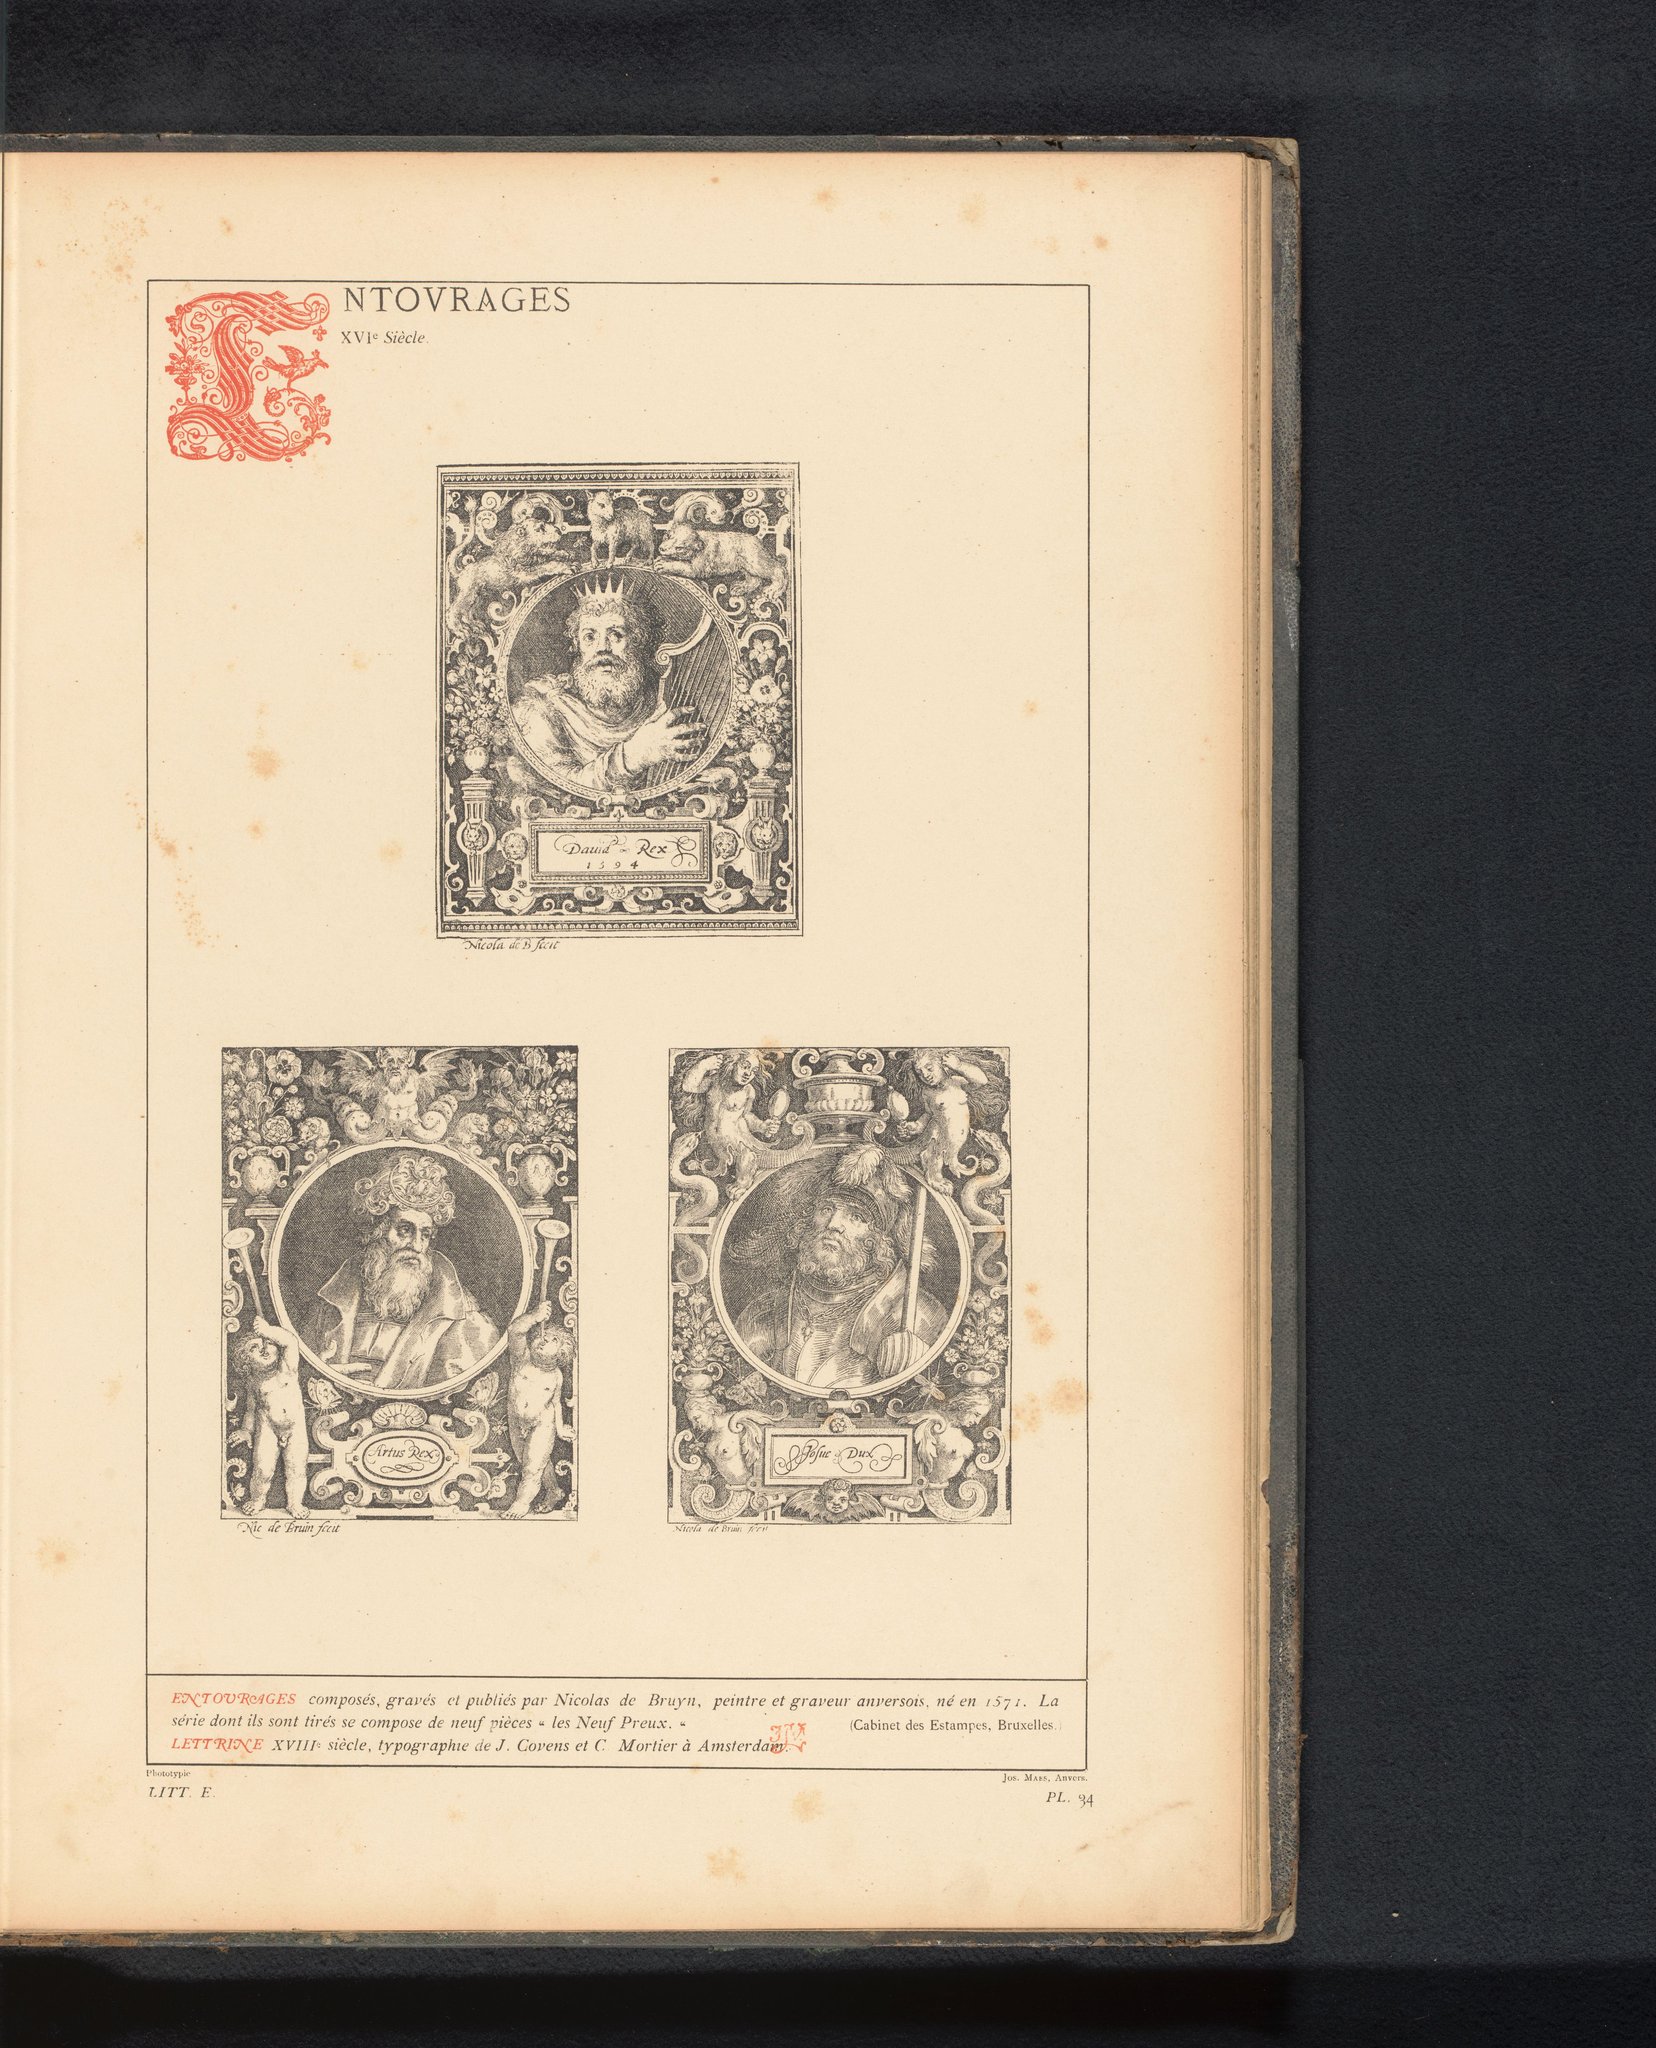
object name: reproduction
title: Reproductie van drie prenten van een portret omringd door grotesken door Nicolaes de Bruyn, afgebeeld Koning David, Koning Arthur en vermoedelijk Frederic Josue, hertog van Saksen-Coburg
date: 1875-1880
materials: paper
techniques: photolithography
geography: antwerp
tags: ornament ~ grotesque, historical persons, story of david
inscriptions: inscription: ‘ENTOURAGES composés, gravés (...)’, inscription: ‘LITT. E. - PL. 34’, monogram: ‘JJvY’